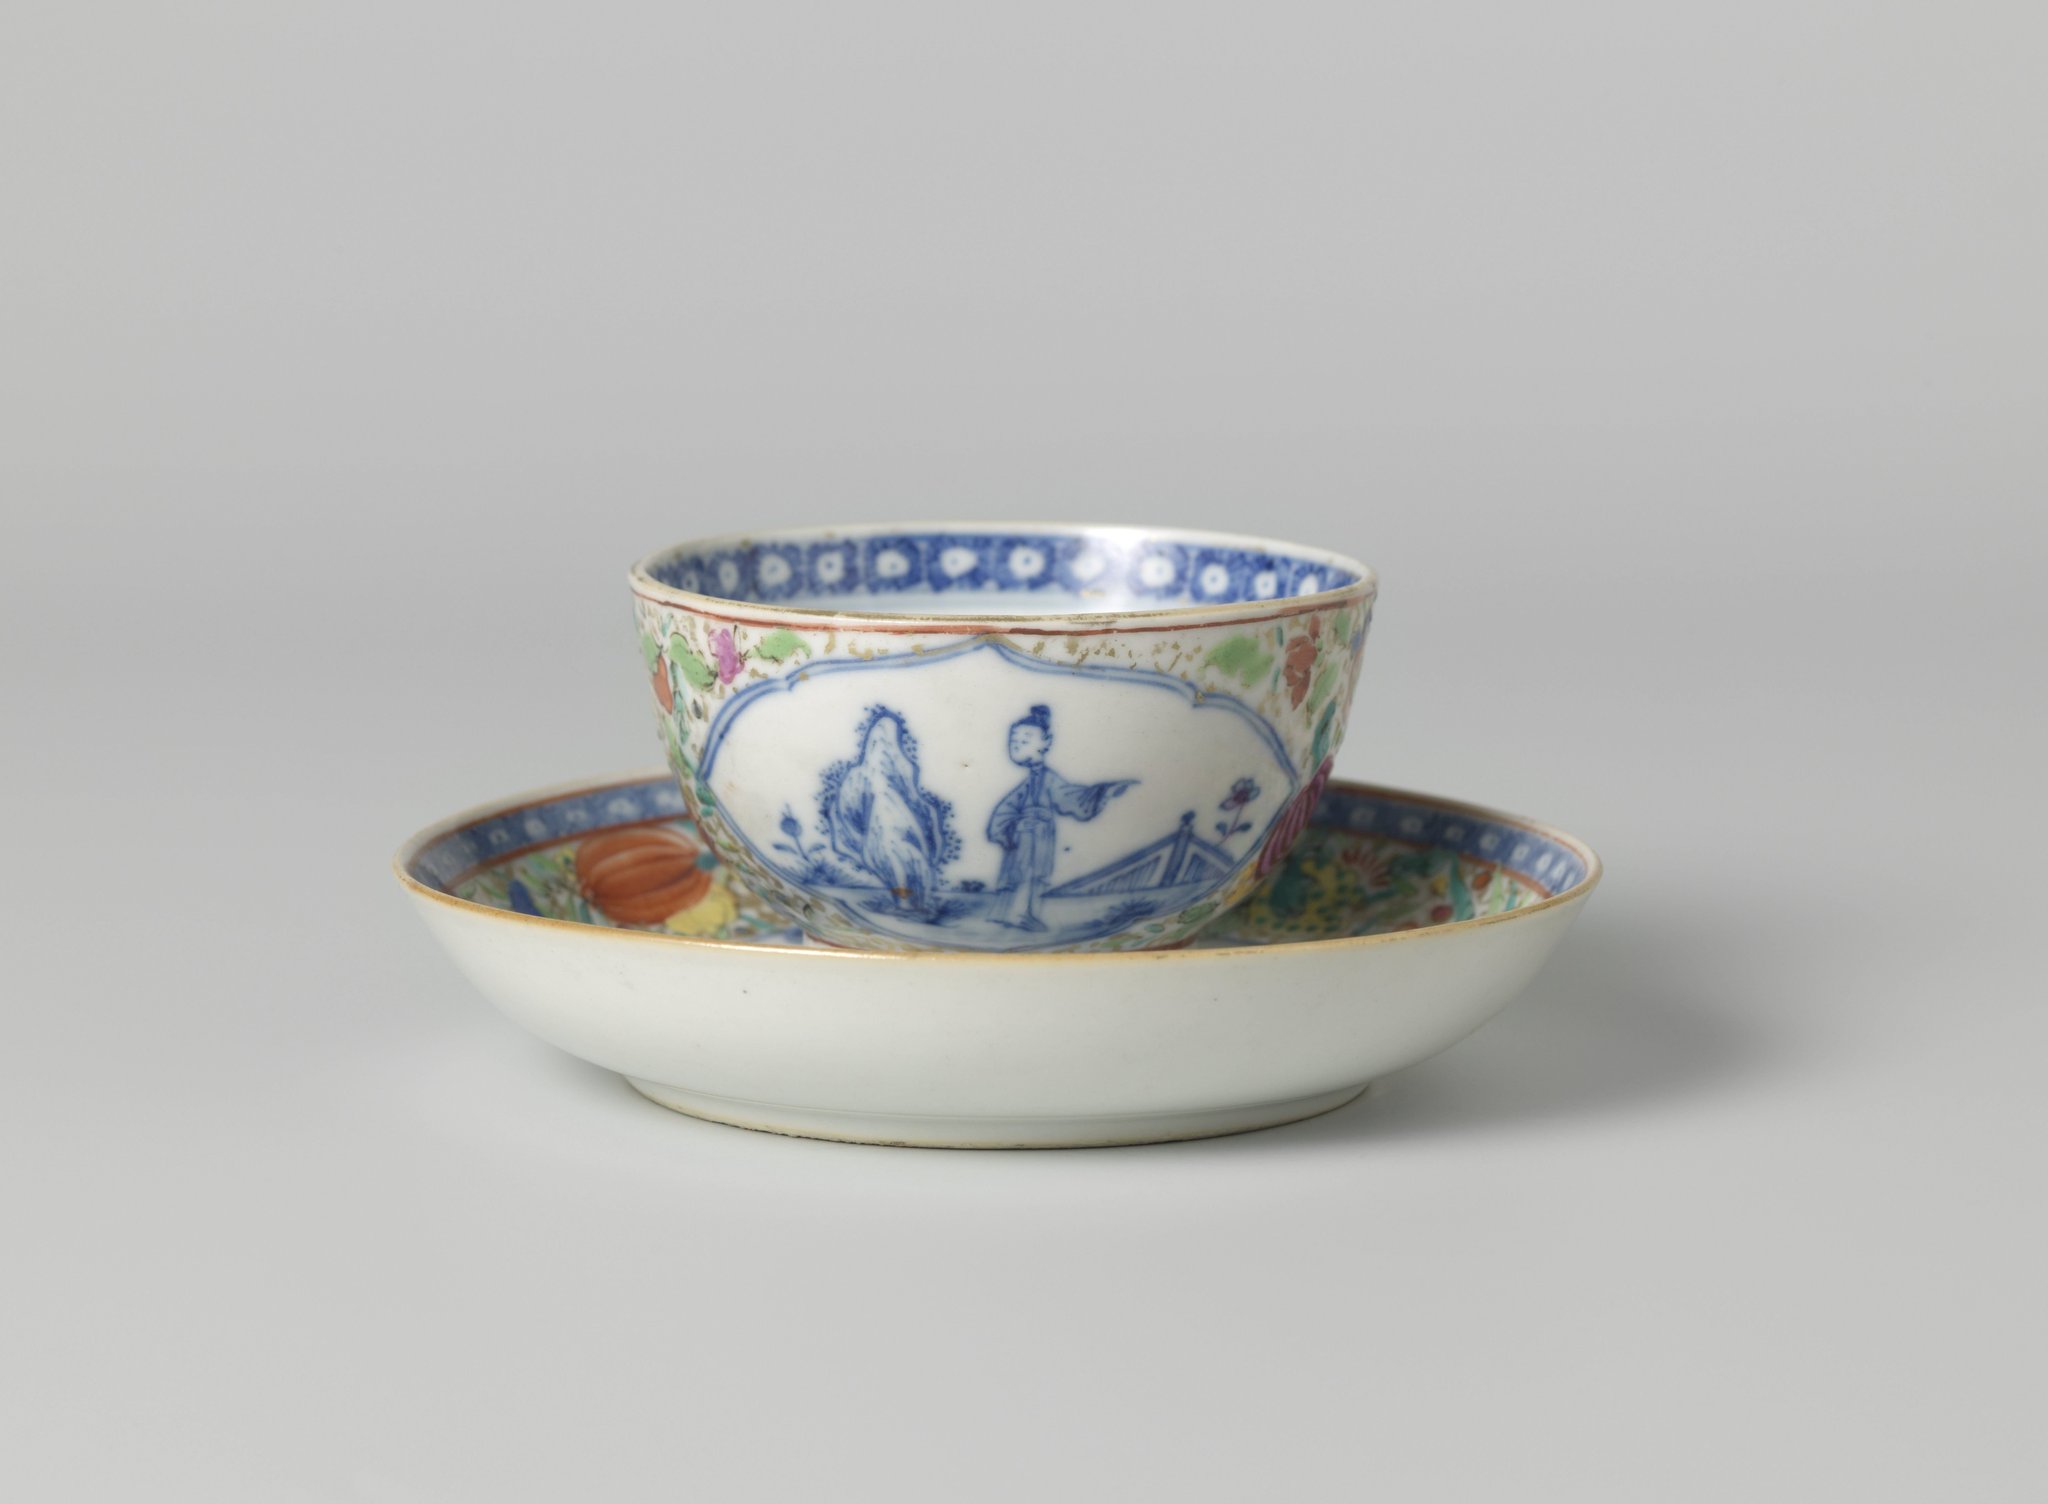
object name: kop en schotel, kop en schotel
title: Straight-sided cup and saucer with two women in a fenced garden and flower scrolls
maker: Anonymous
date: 1750-1774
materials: glaze, gold, paint, porcelain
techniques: firing, gilding, turning, vitrification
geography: china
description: Kop en schotel, versierd met rand van gekleurde bloemen en voorstelling van chinese vrouwen.